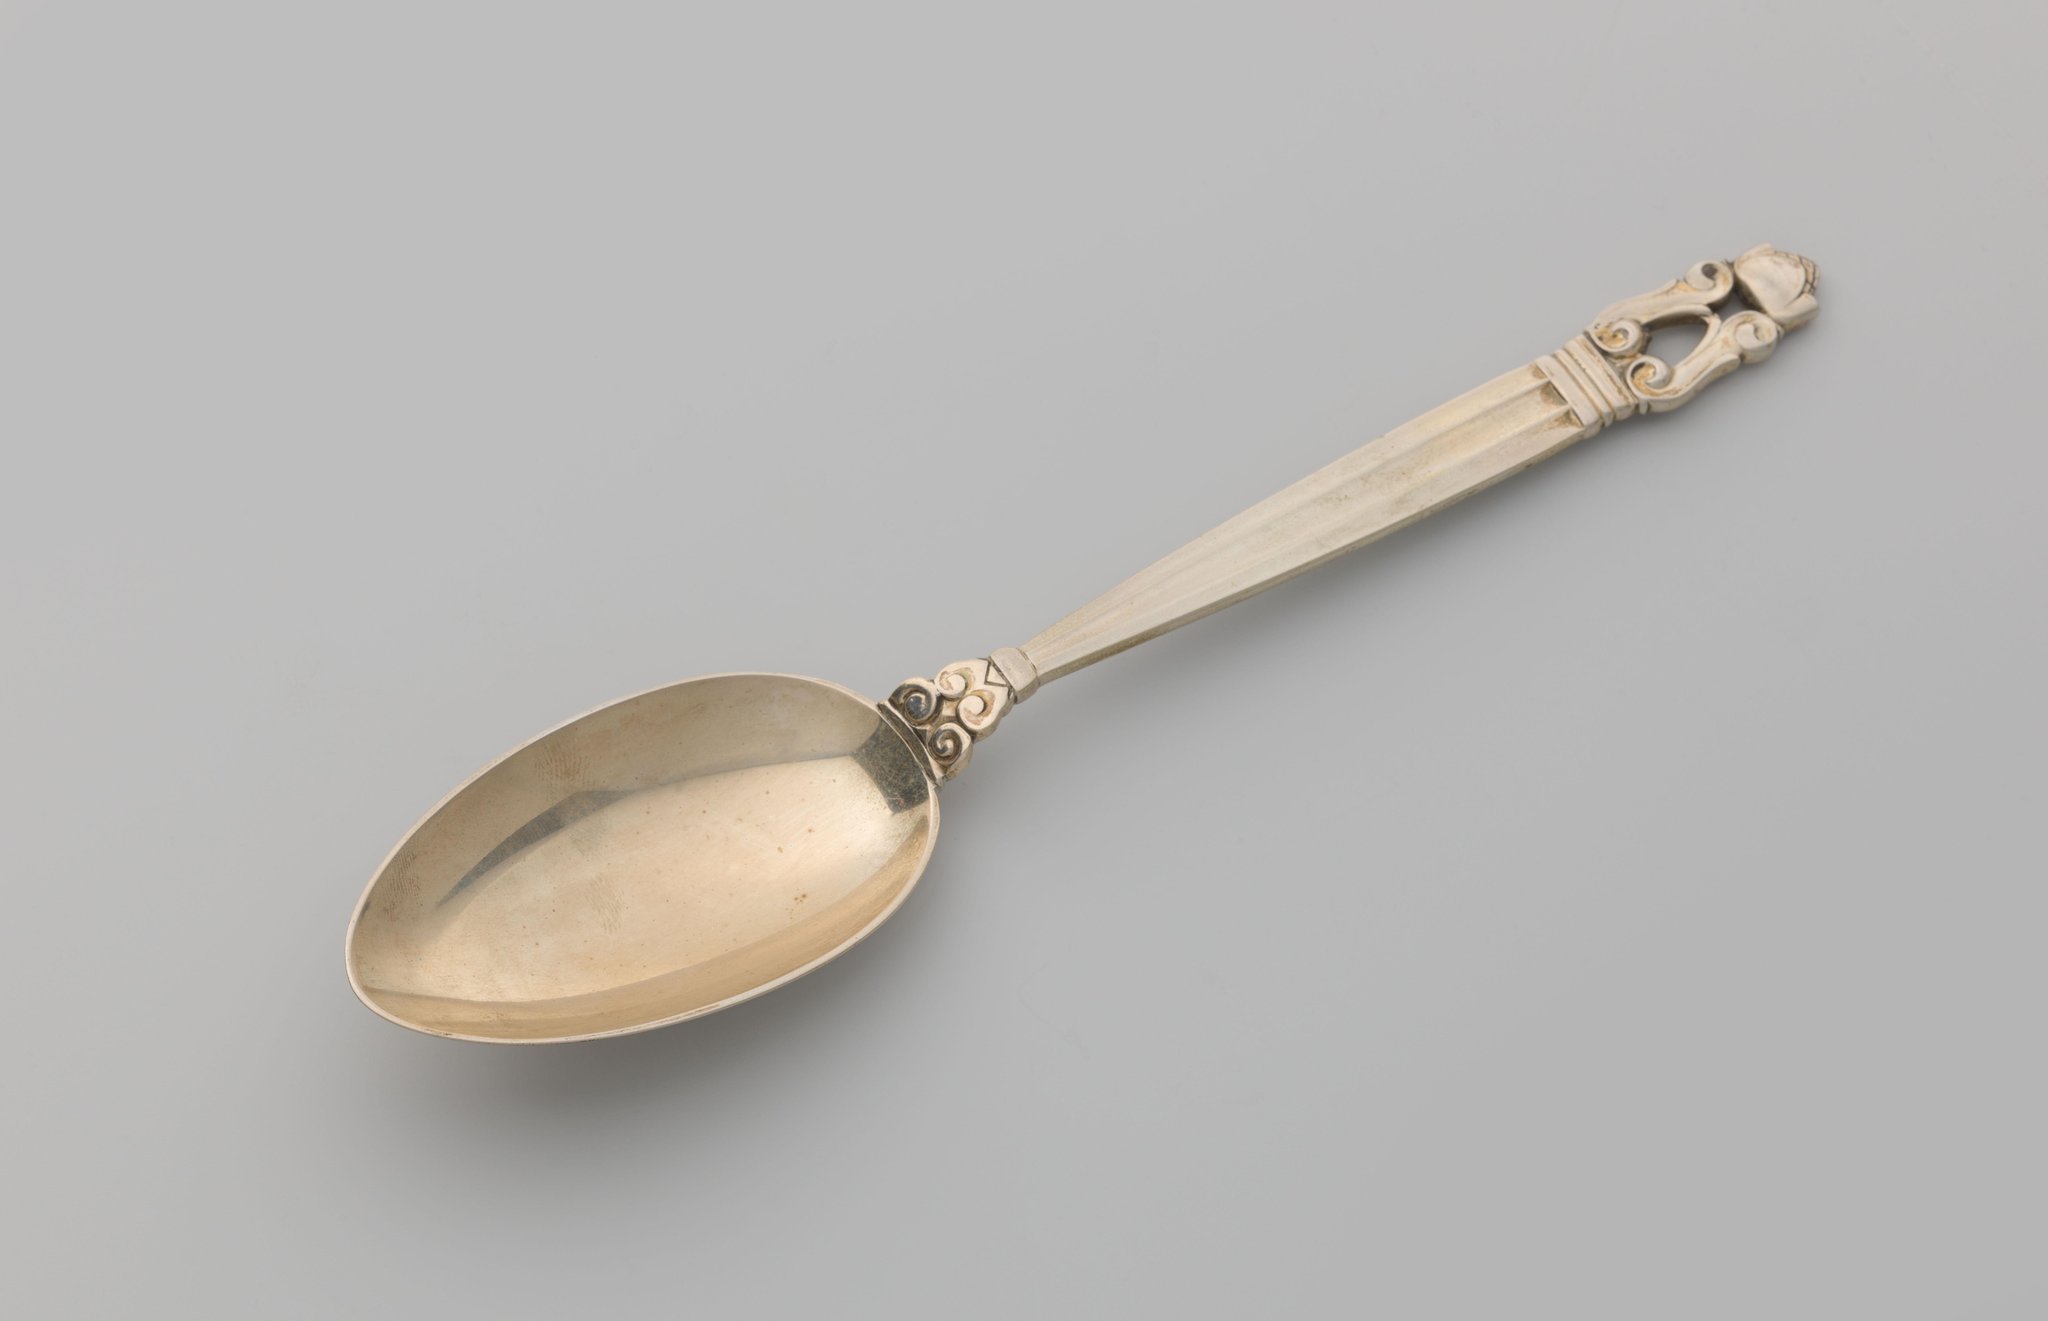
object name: spoon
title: Lepel van zilver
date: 1915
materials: silver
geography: copenhagen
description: Lepel van zilver met eivormige bak, model 'Konge'. De zich verbredende gecanneleerde steel wordt bekroond door een motief van S-voluten waarboven een denneappel in bladeren.